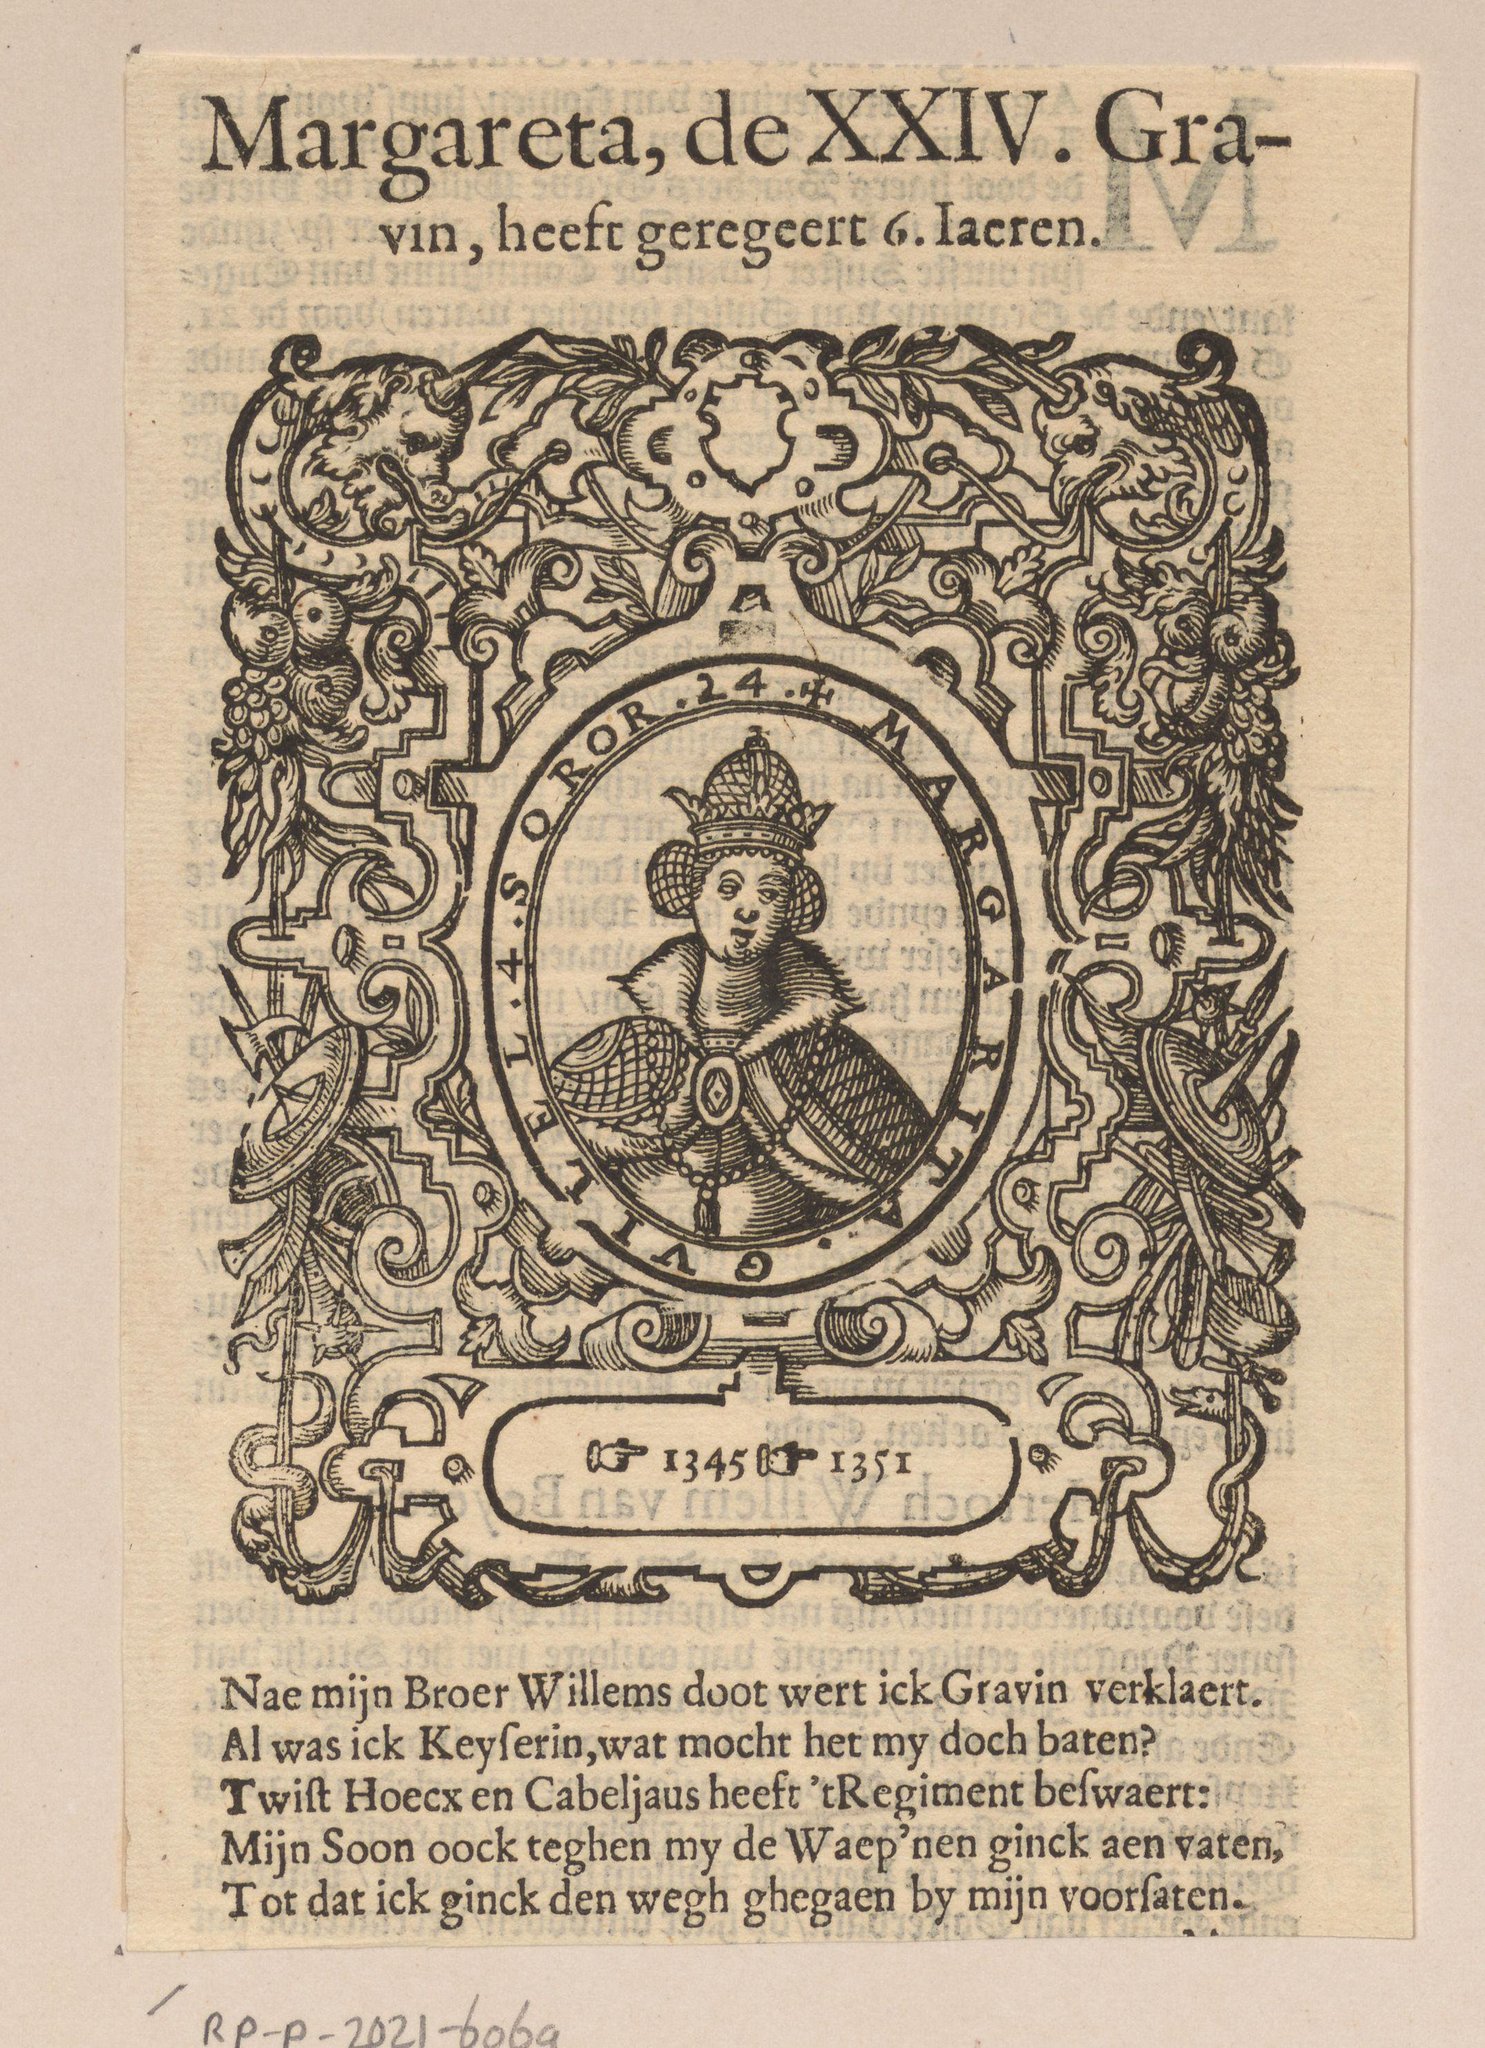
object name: print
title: Portret van Margaretha II van Henegouwen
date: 1636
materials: paper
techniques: letterpress printing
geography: amsterdam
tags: sceptre, staff (symbol of sovereignty) - bb - female ruler, historical persons - bb - woman, crown (symbol of sovereignty) - bb - female ruler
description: Prent uit: Scriverius, Petrus. Beschrivinge van Out Batavien (...). Amsterdam: Jan Cloppenburg, 1636. Prent met andere omlijsting gebruikt in editie uit 1646. Prent eerder gebruikt in publicaties uit 1606 en 1609, zie Van Someren.